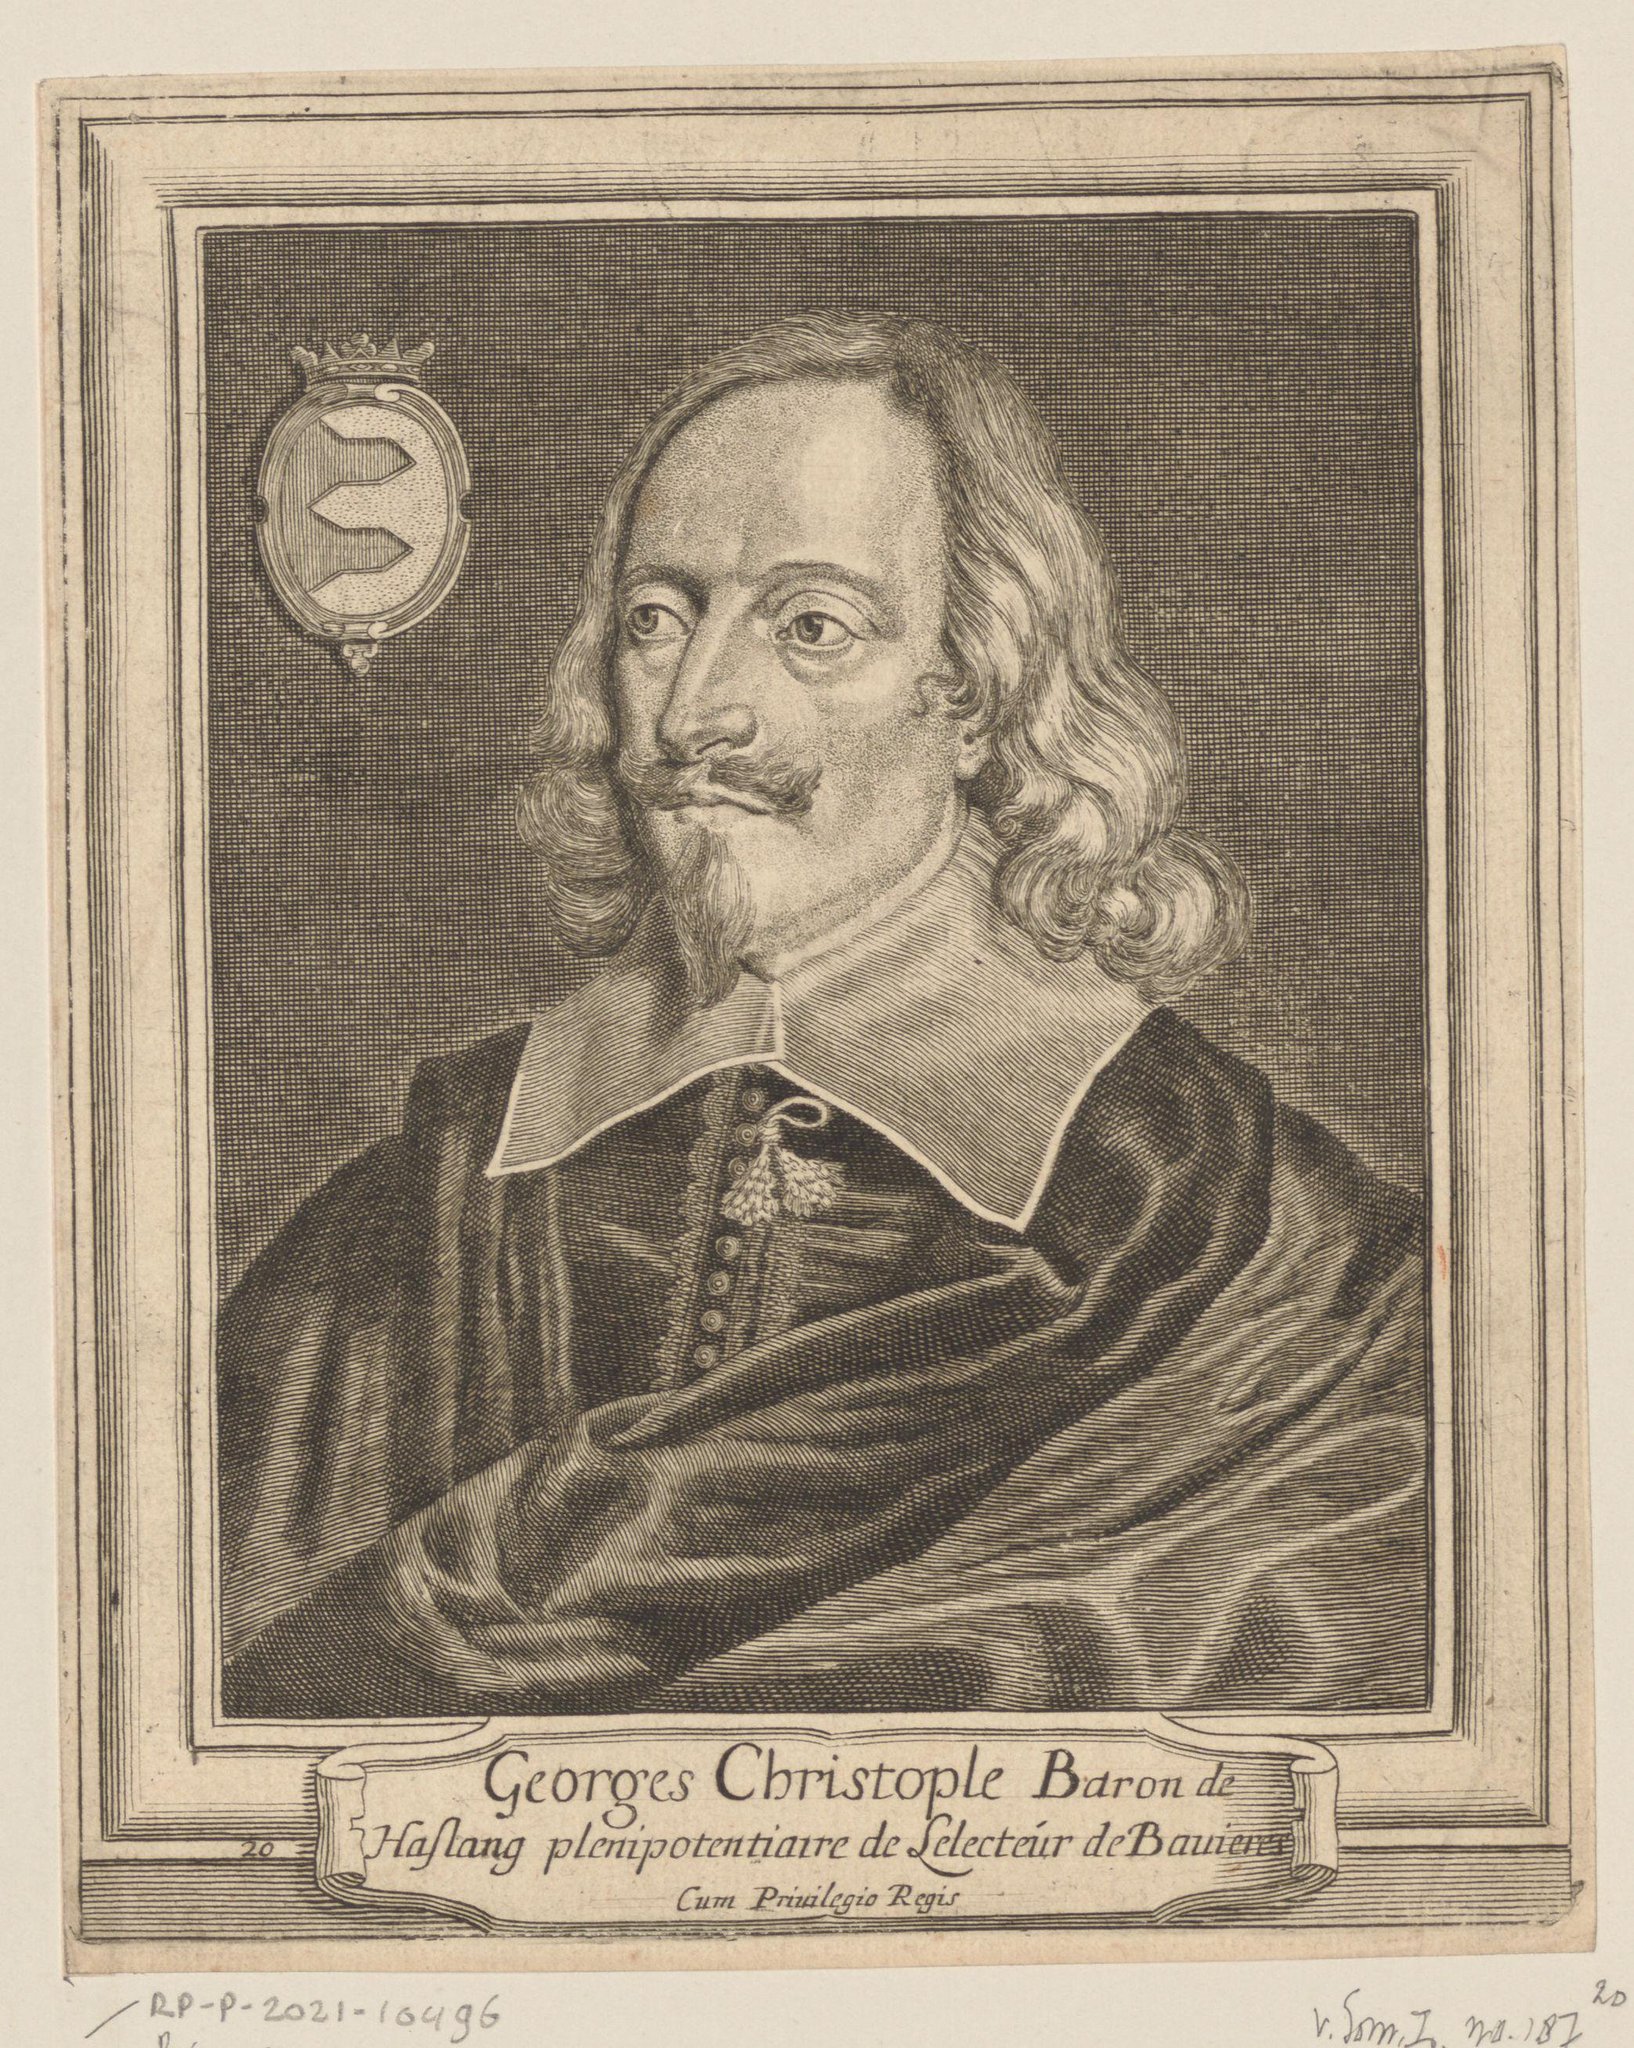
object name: print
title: Portret van Georg Christoph von Haslang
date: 1648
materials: paper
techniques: engraving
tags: politician, historical persons, negotiations, conference ~ diplomacy, armorial bearing, heraldry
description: Prent waarschijnlijk uit: Legatorum omnium tam Monasterij, quam Osnabrugae (...). Parijs: s.n., 1648. Latere staat gebruikt in: Bignon, François. Les portraictz au naturel avec les armoiries et blasons noms et qualitez de messieurs les plénipotentiaires assemblez à Munster et Osnaburg (...). Parijs: Henry Sara en Jean Paslé, [1648].